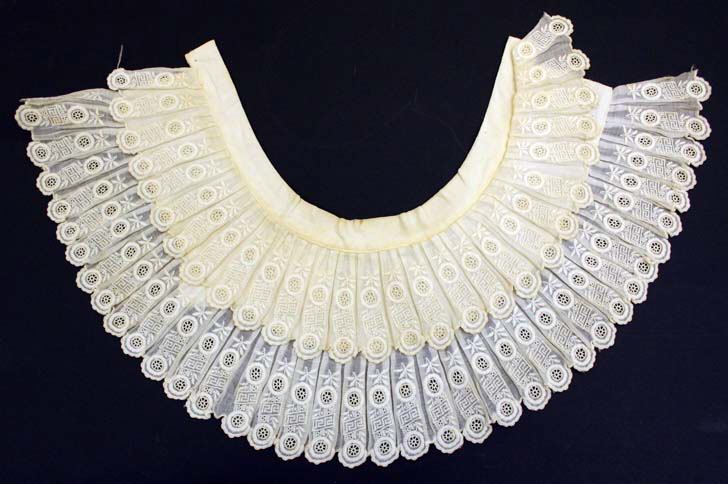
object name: collar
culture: american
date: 1883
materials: cotton